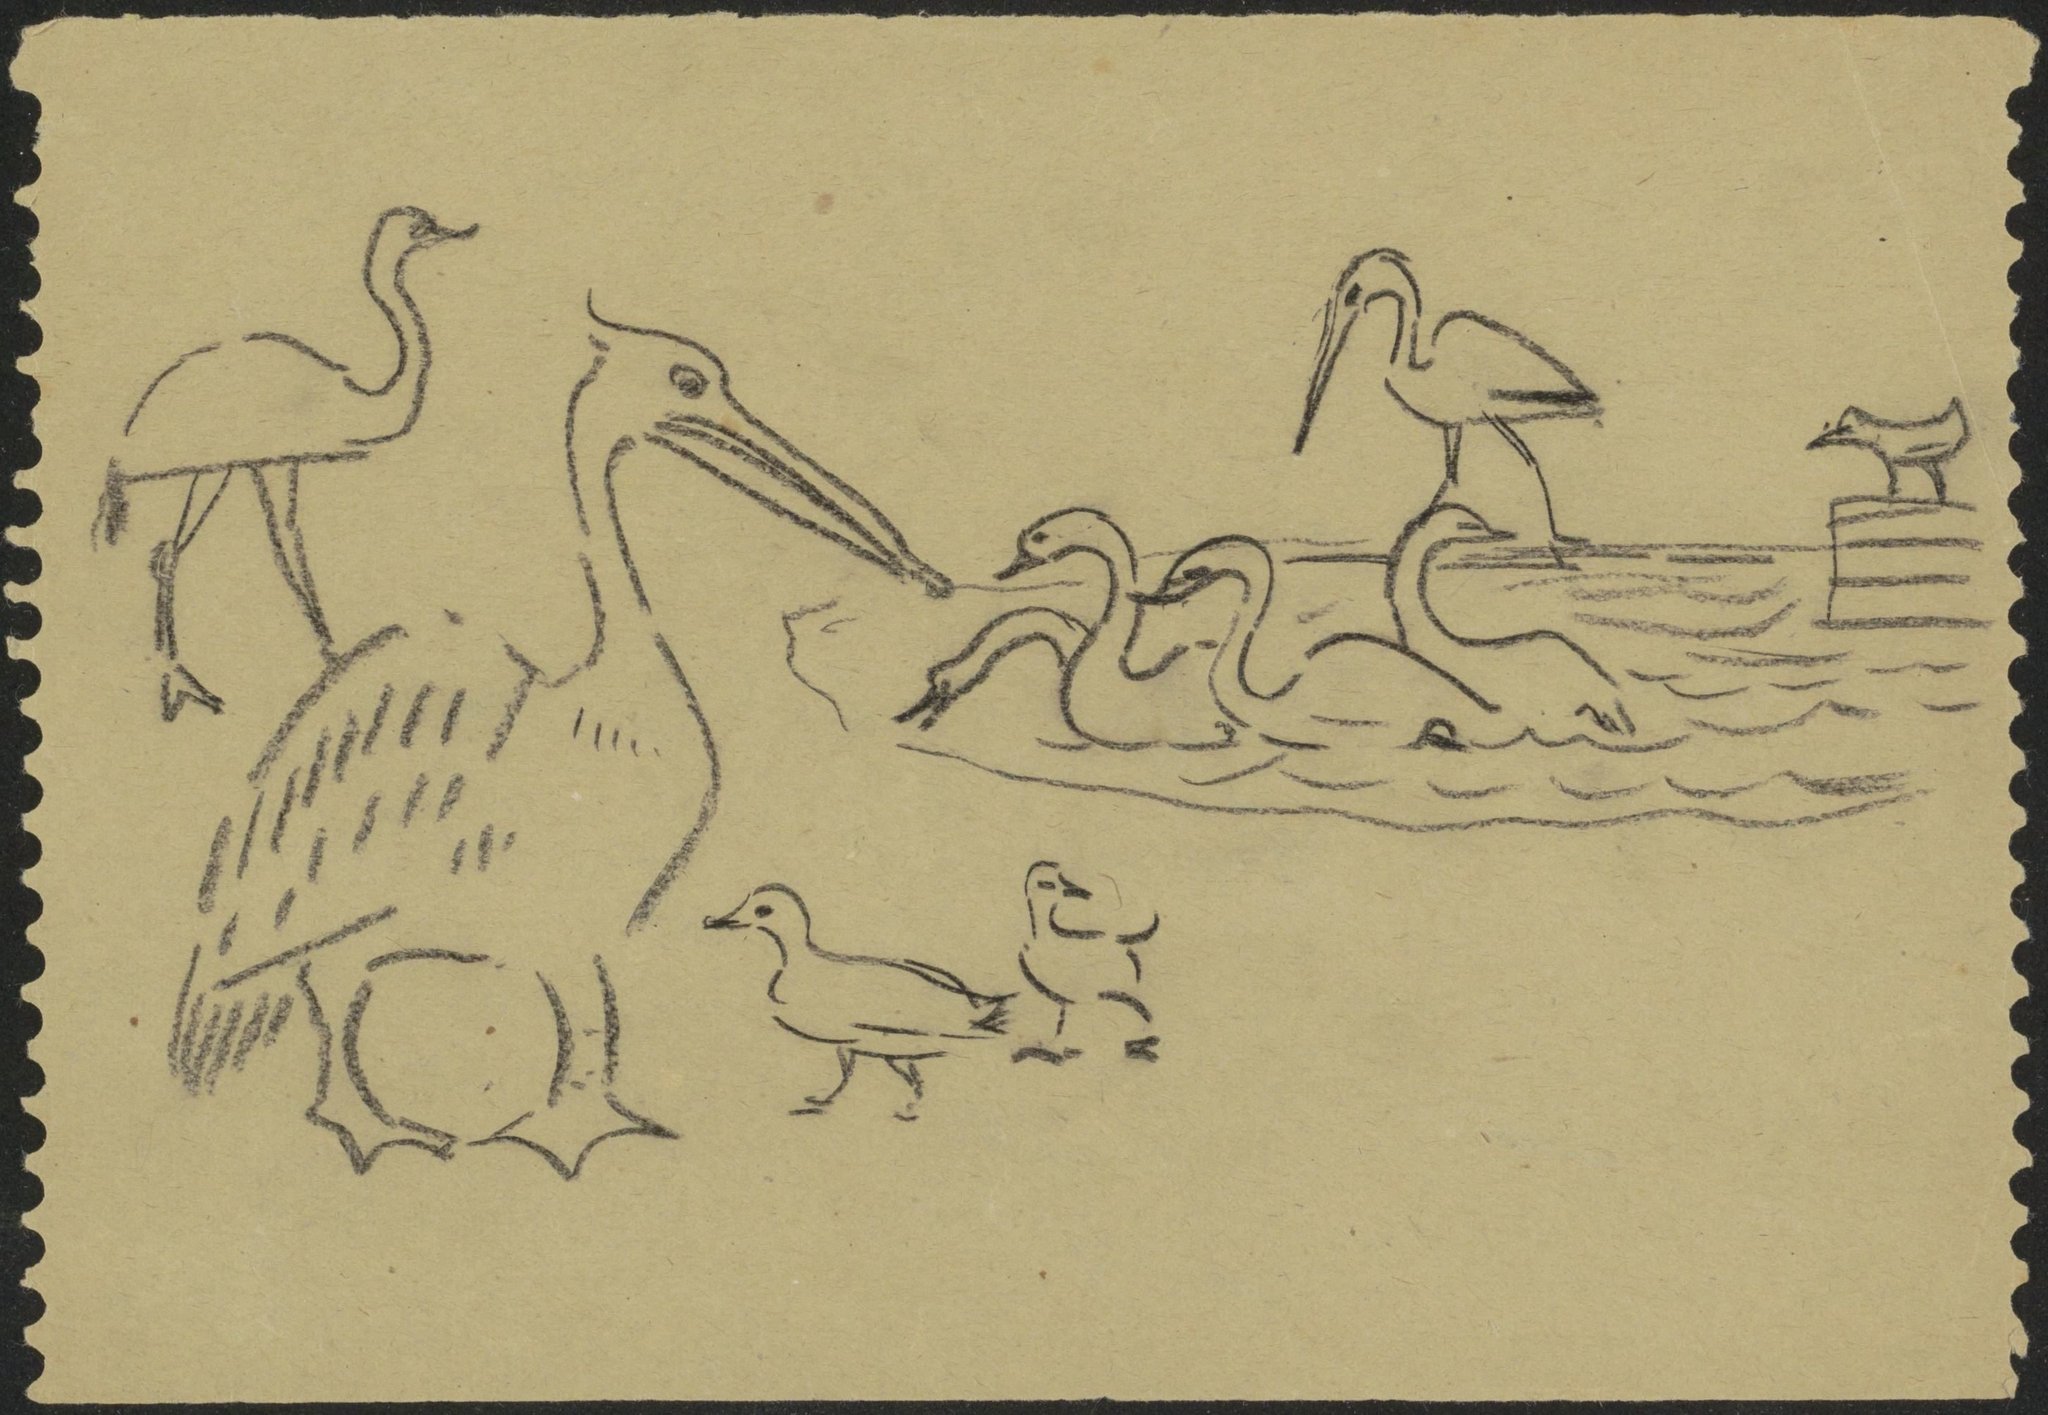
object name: drawing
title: Watervogels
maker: gerrit willem dijsselhof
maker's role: designer, draughtsman, print maker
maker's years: 1866-1924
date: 1904-1906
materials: chalk, paper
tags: water-birds: duck, water-birds: pelican